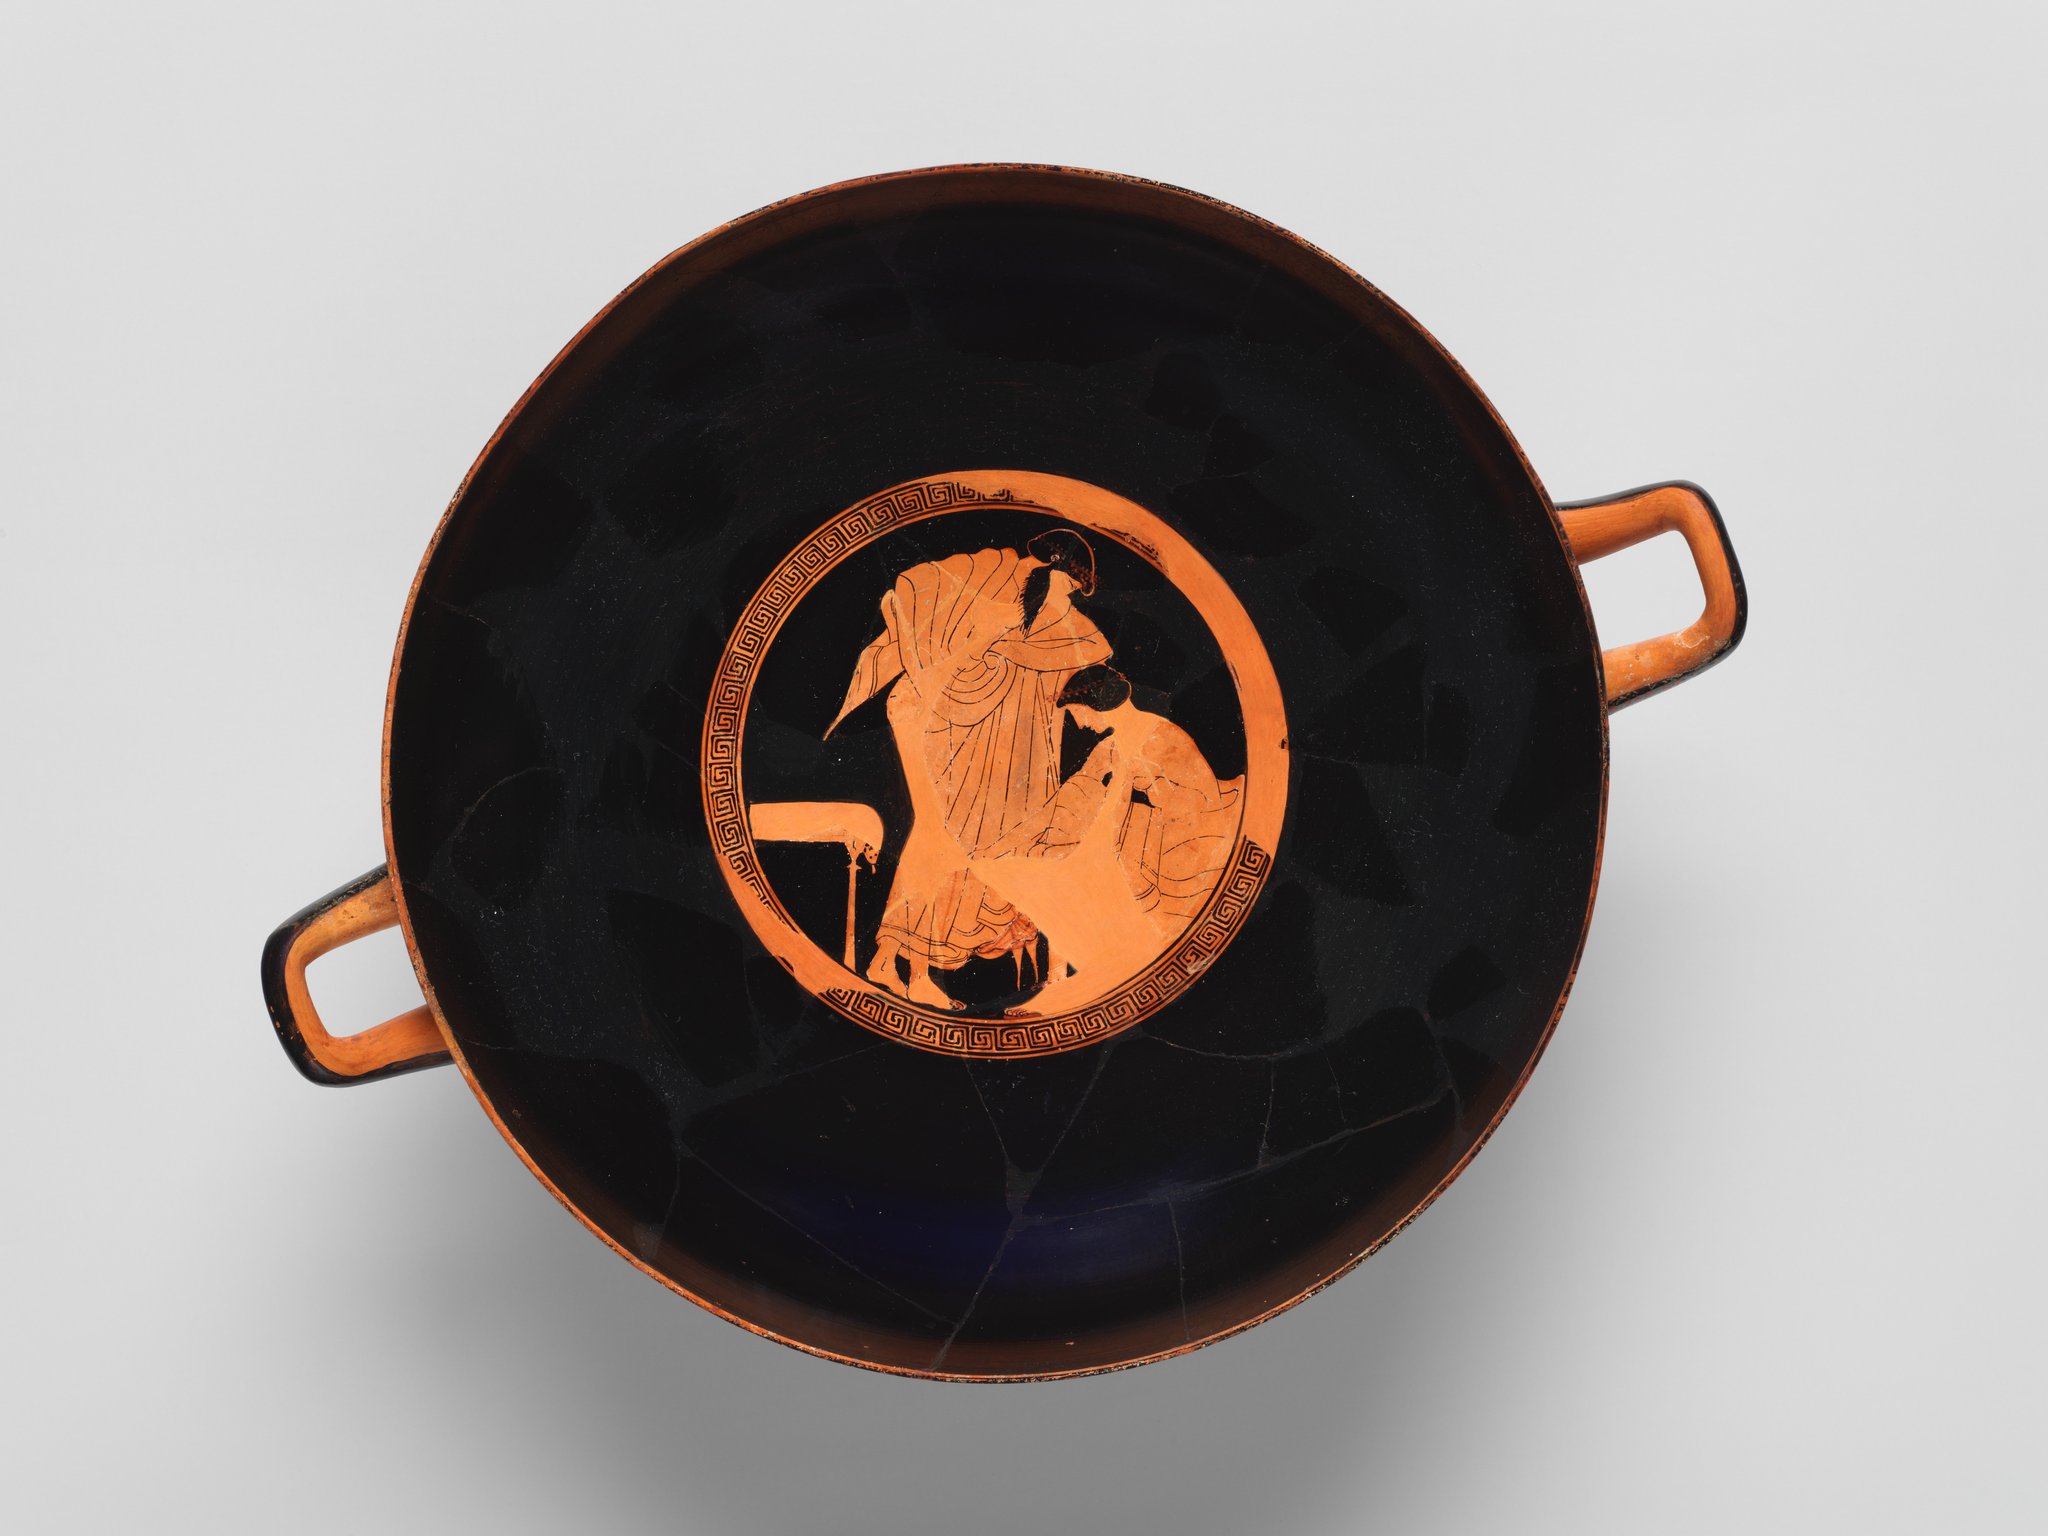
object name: kylix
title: Terracotta kylix (drinking cup)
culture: greek, attic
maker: hieron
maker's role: artist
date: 480 BCE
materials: terracotta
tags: men